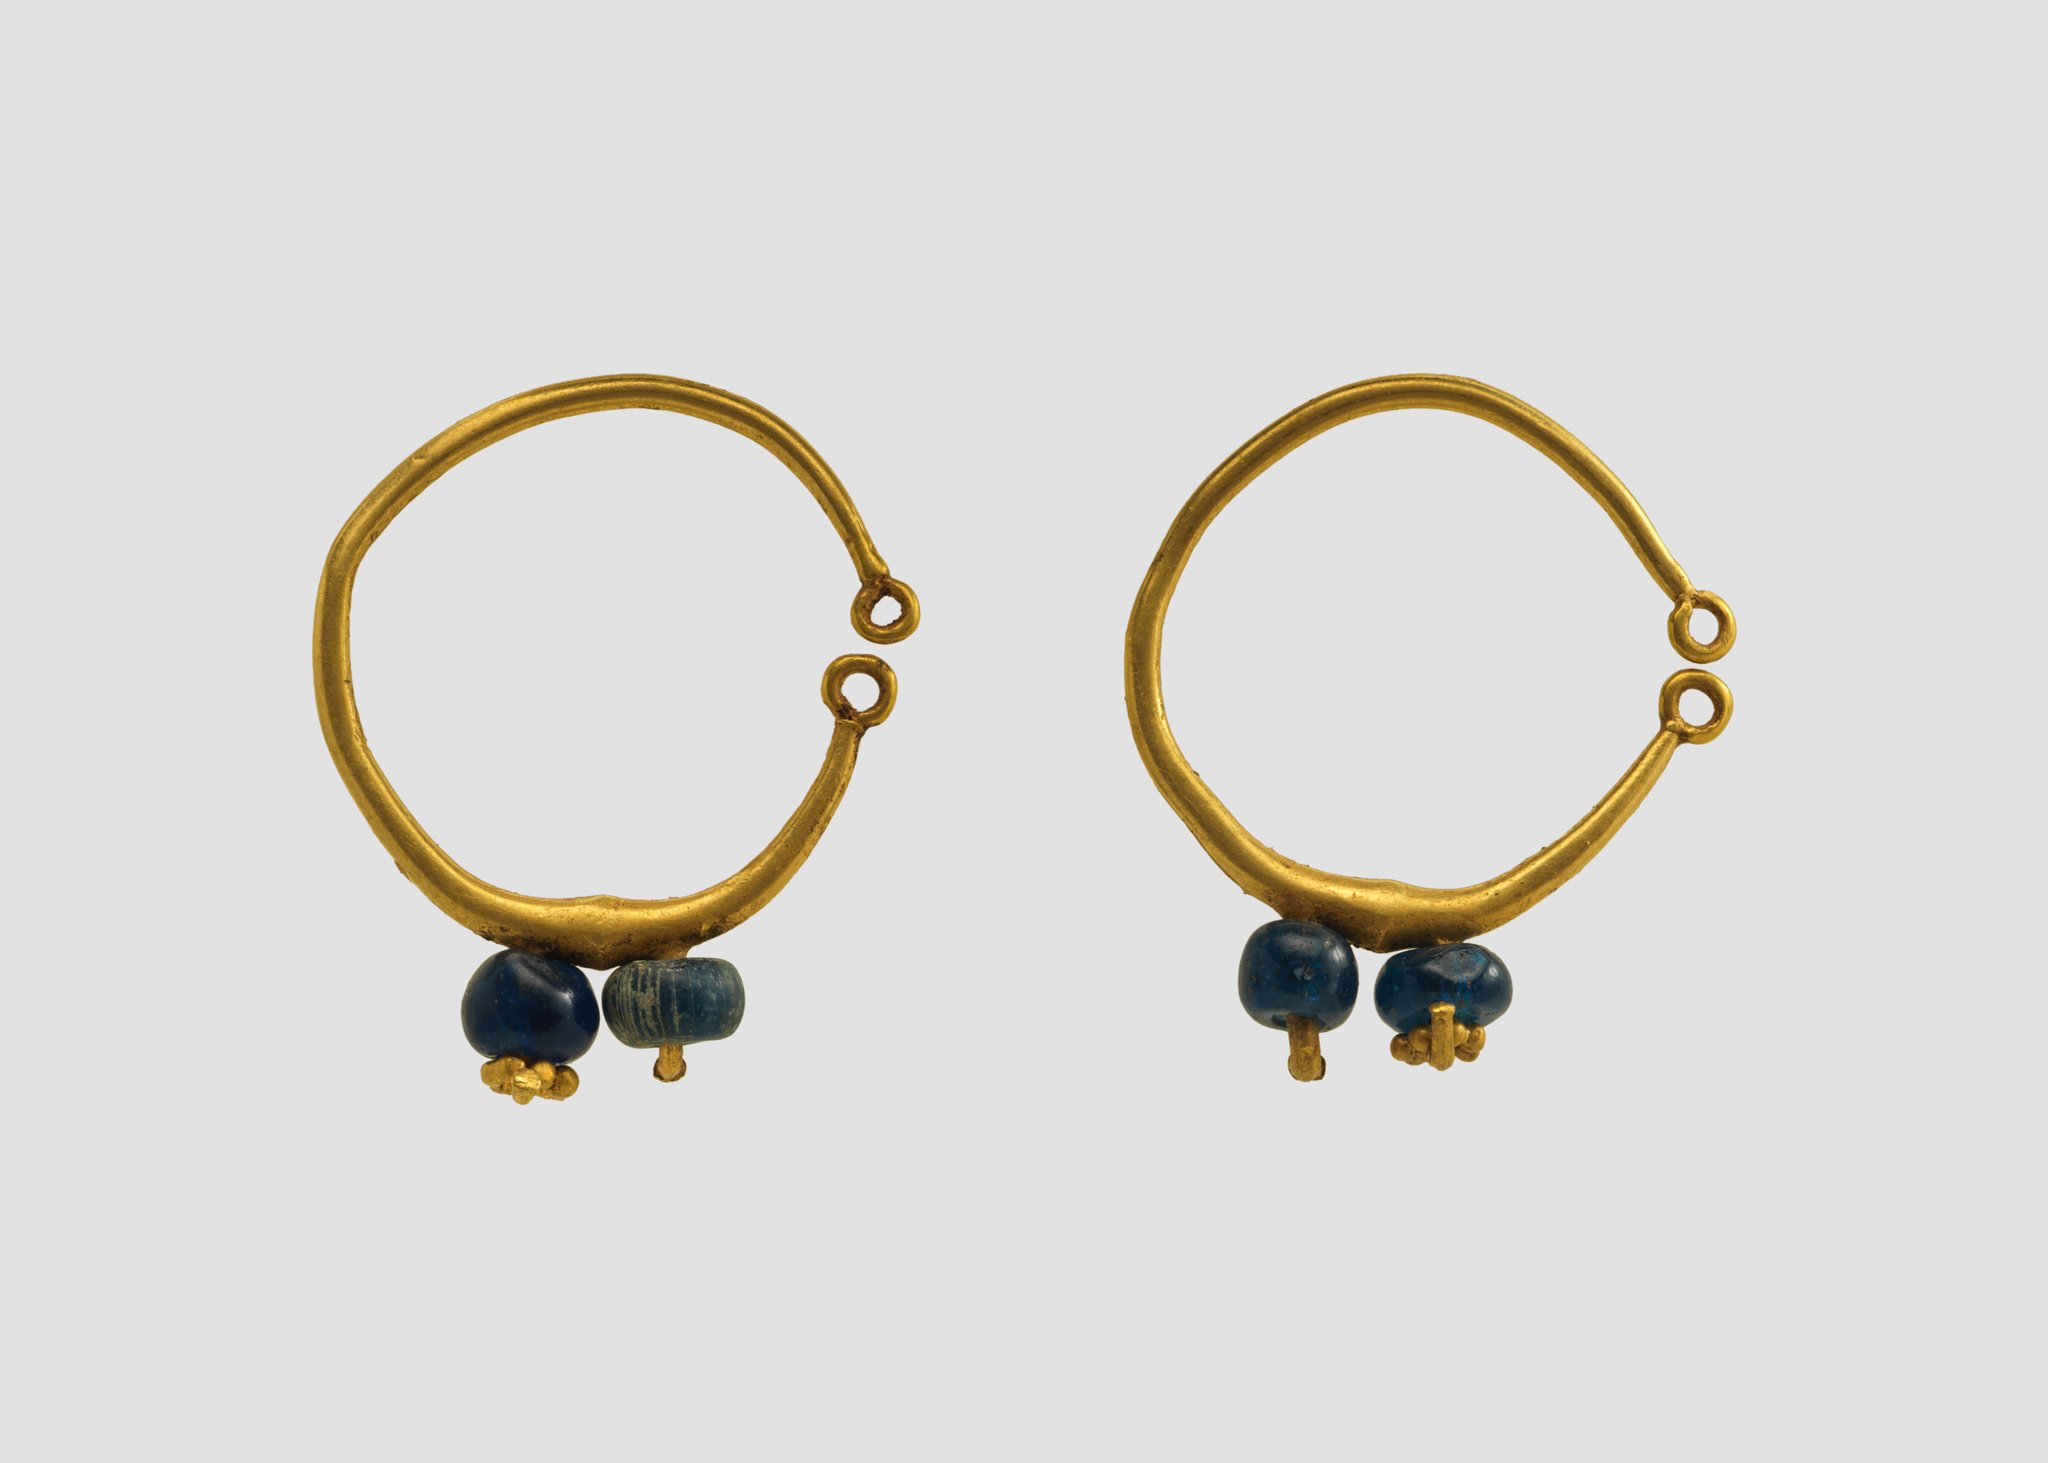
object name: earring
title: Earrings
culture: sasanian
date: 201-700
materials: gold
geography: iran